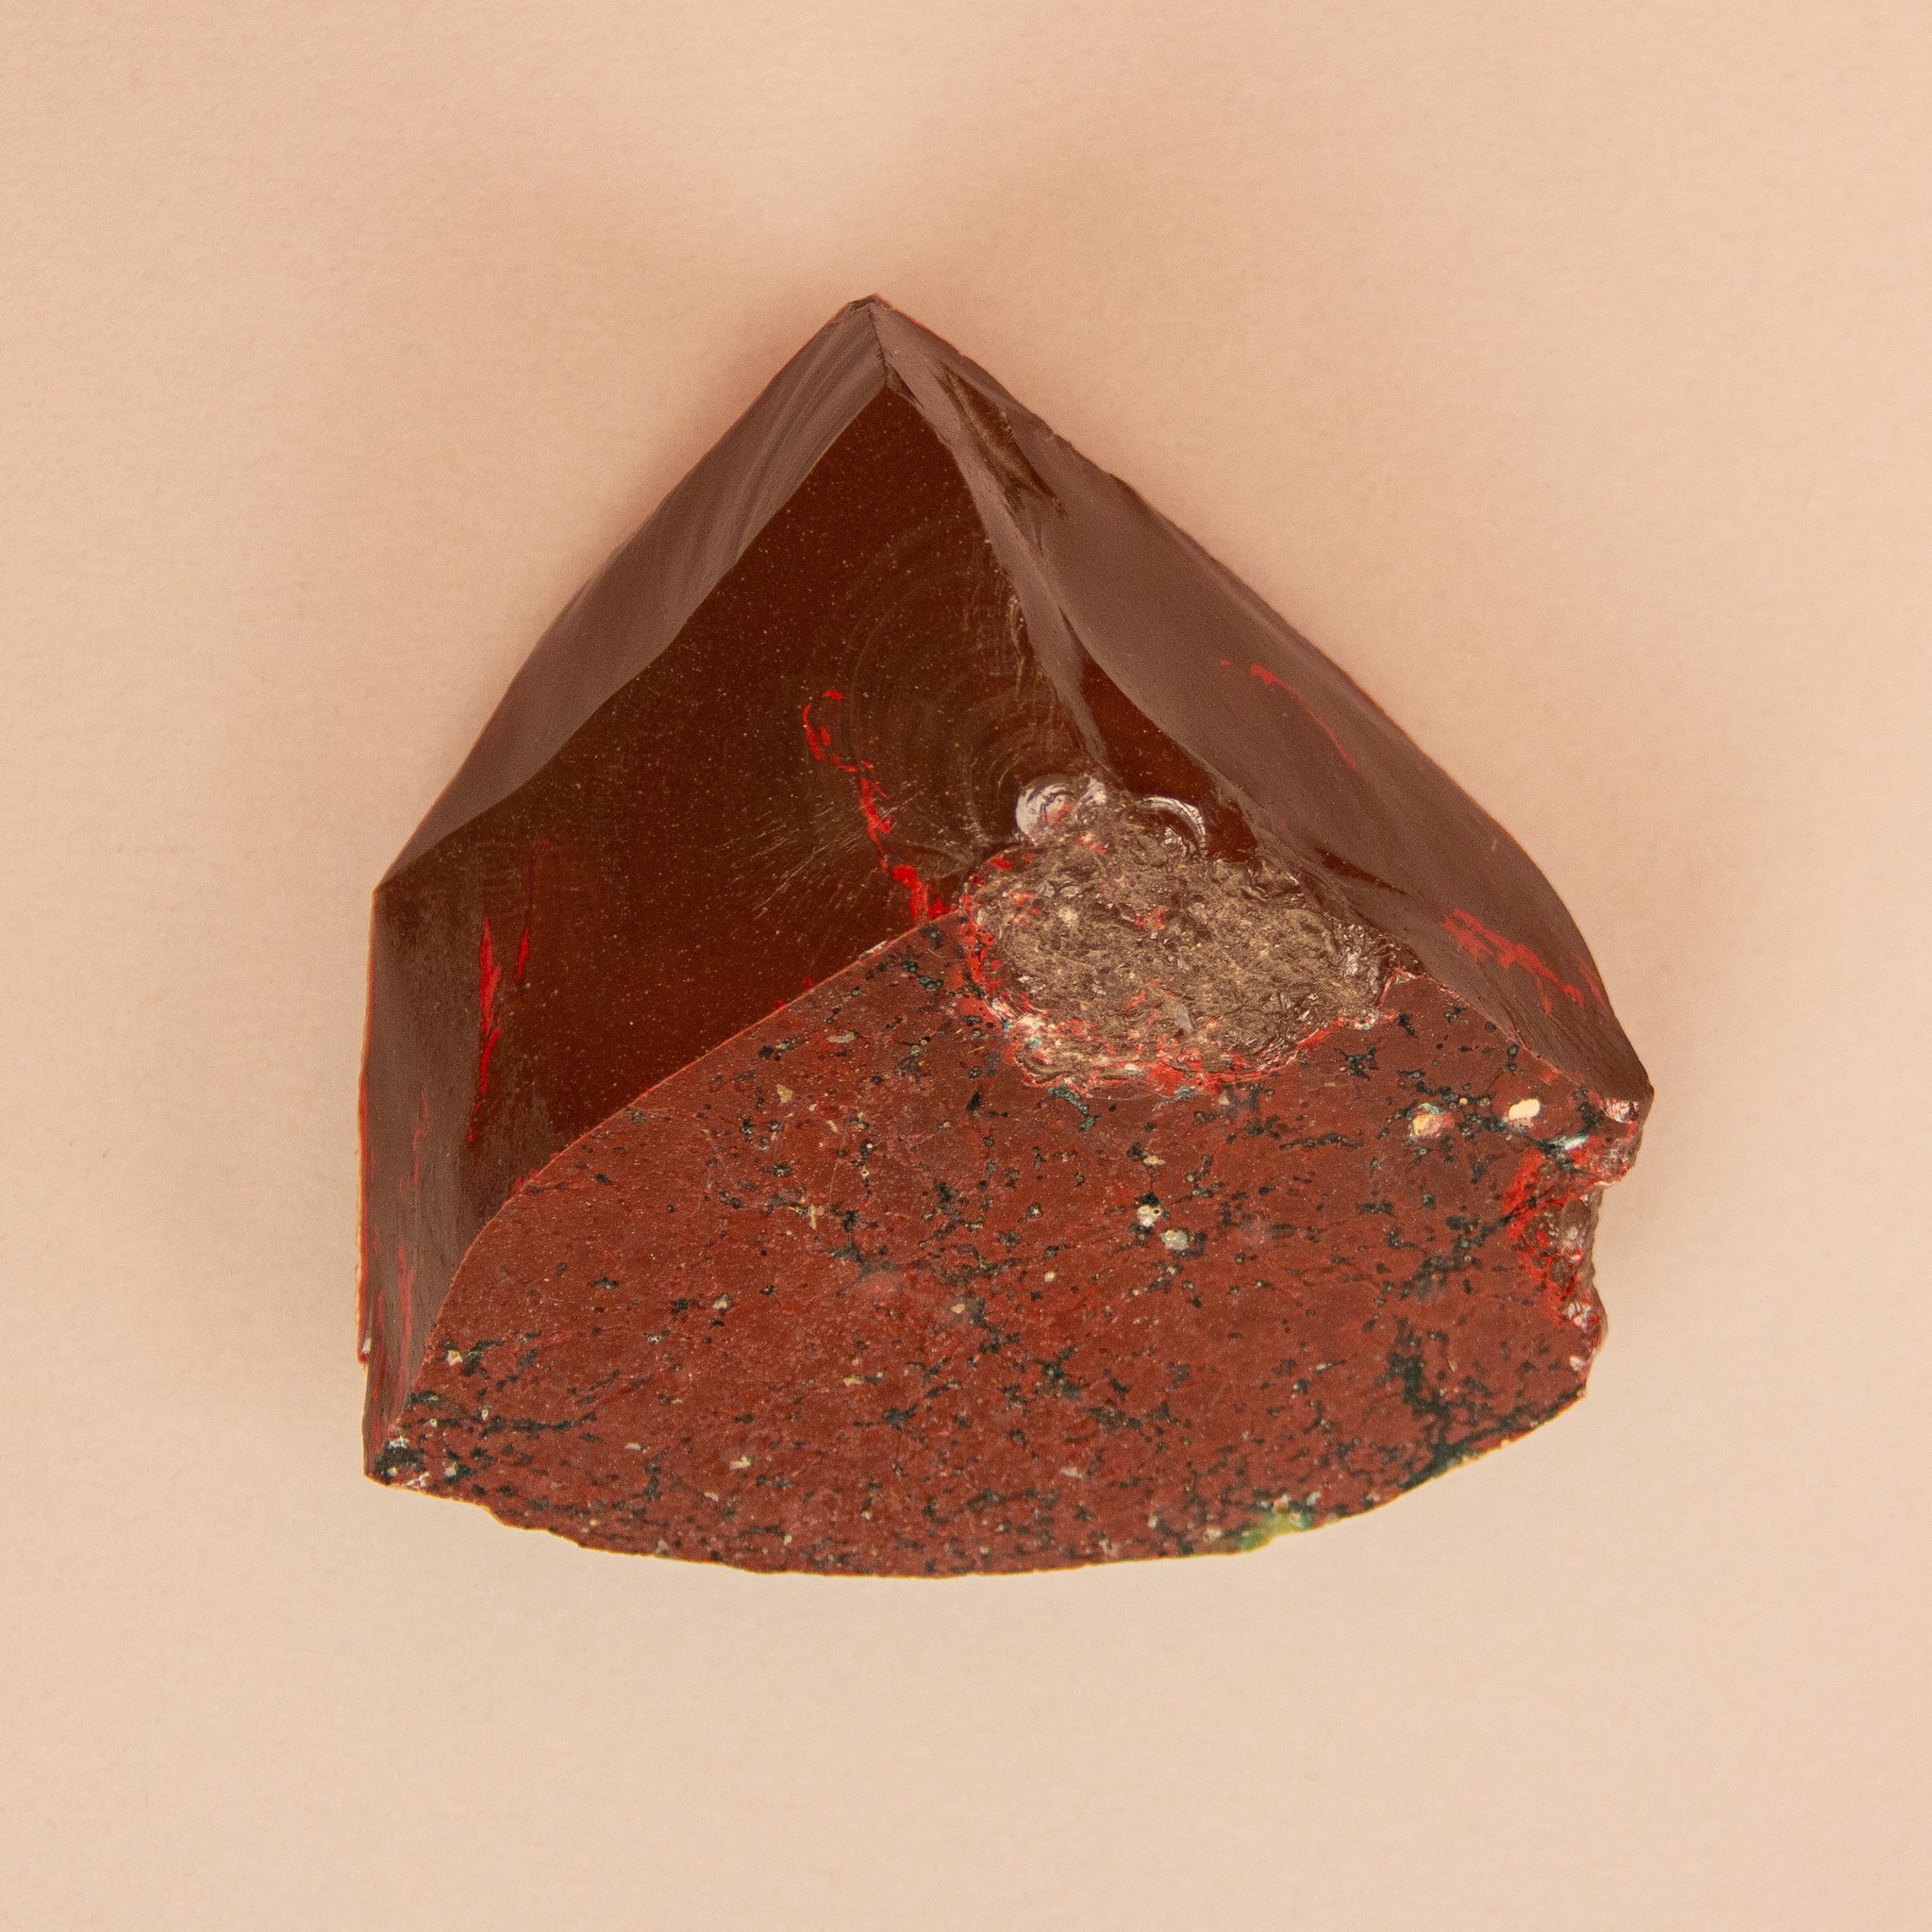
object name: glaze clump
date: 1001-1200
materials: glaze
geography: iran